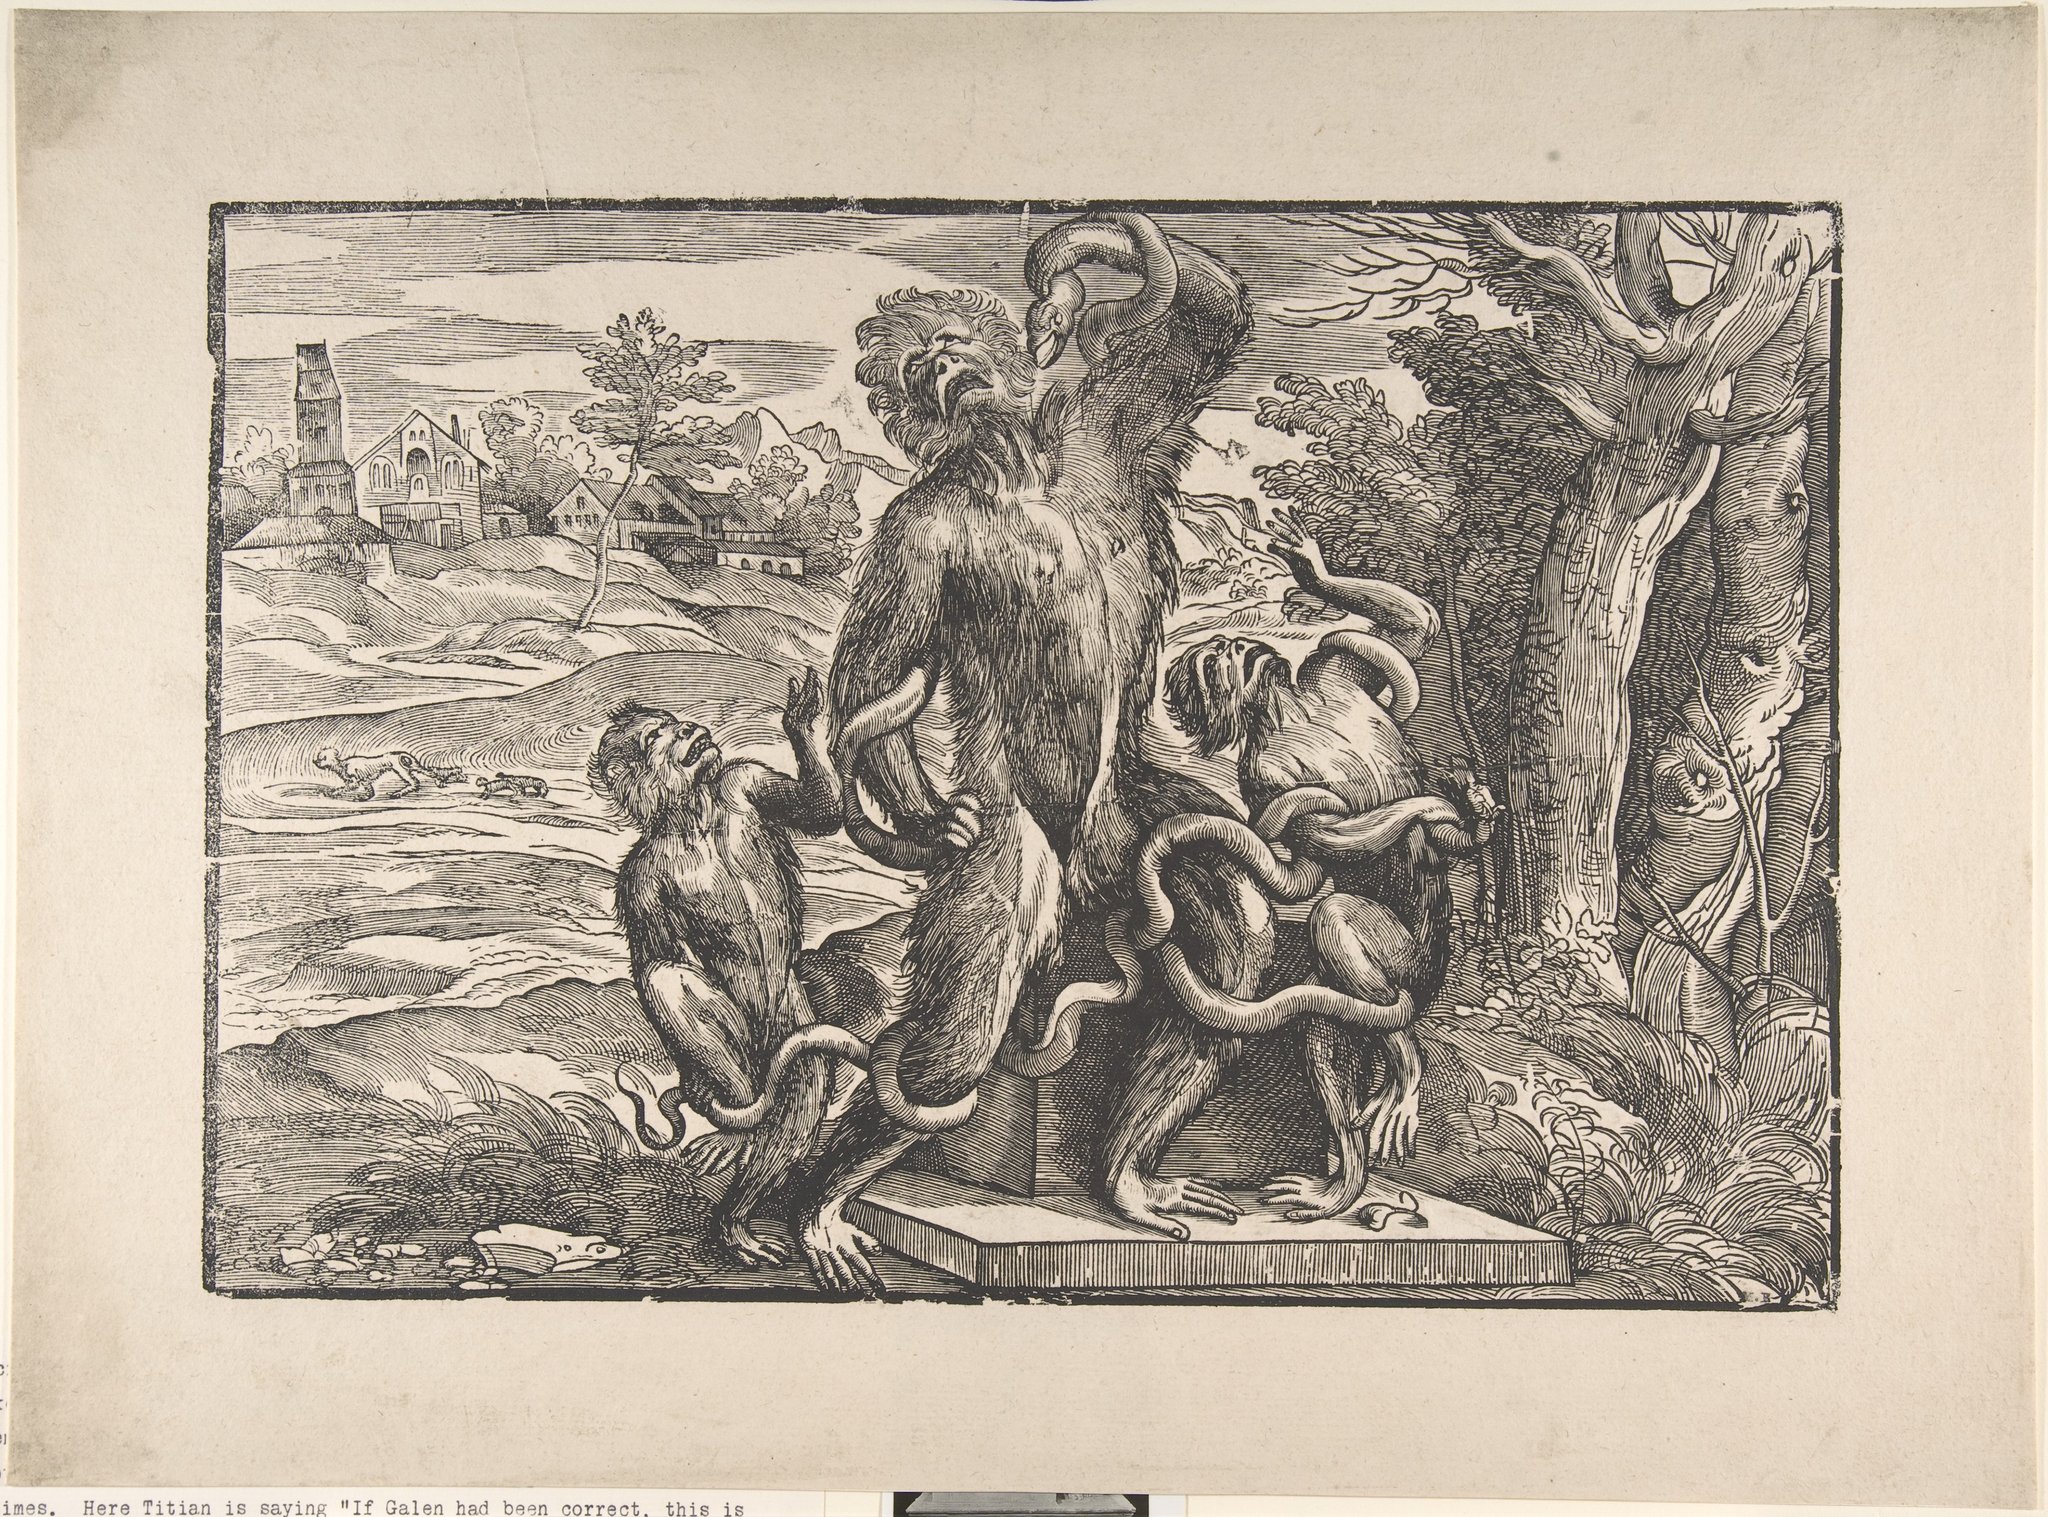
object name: print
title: Caricature of the Laocoön scuptural group, excavated in Rome in 1506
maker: nicolò boldrini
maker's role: artist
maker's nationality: italian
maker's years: 1500-1566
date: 1540-1545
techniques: woodcut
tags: monkeys,serpents,caricature